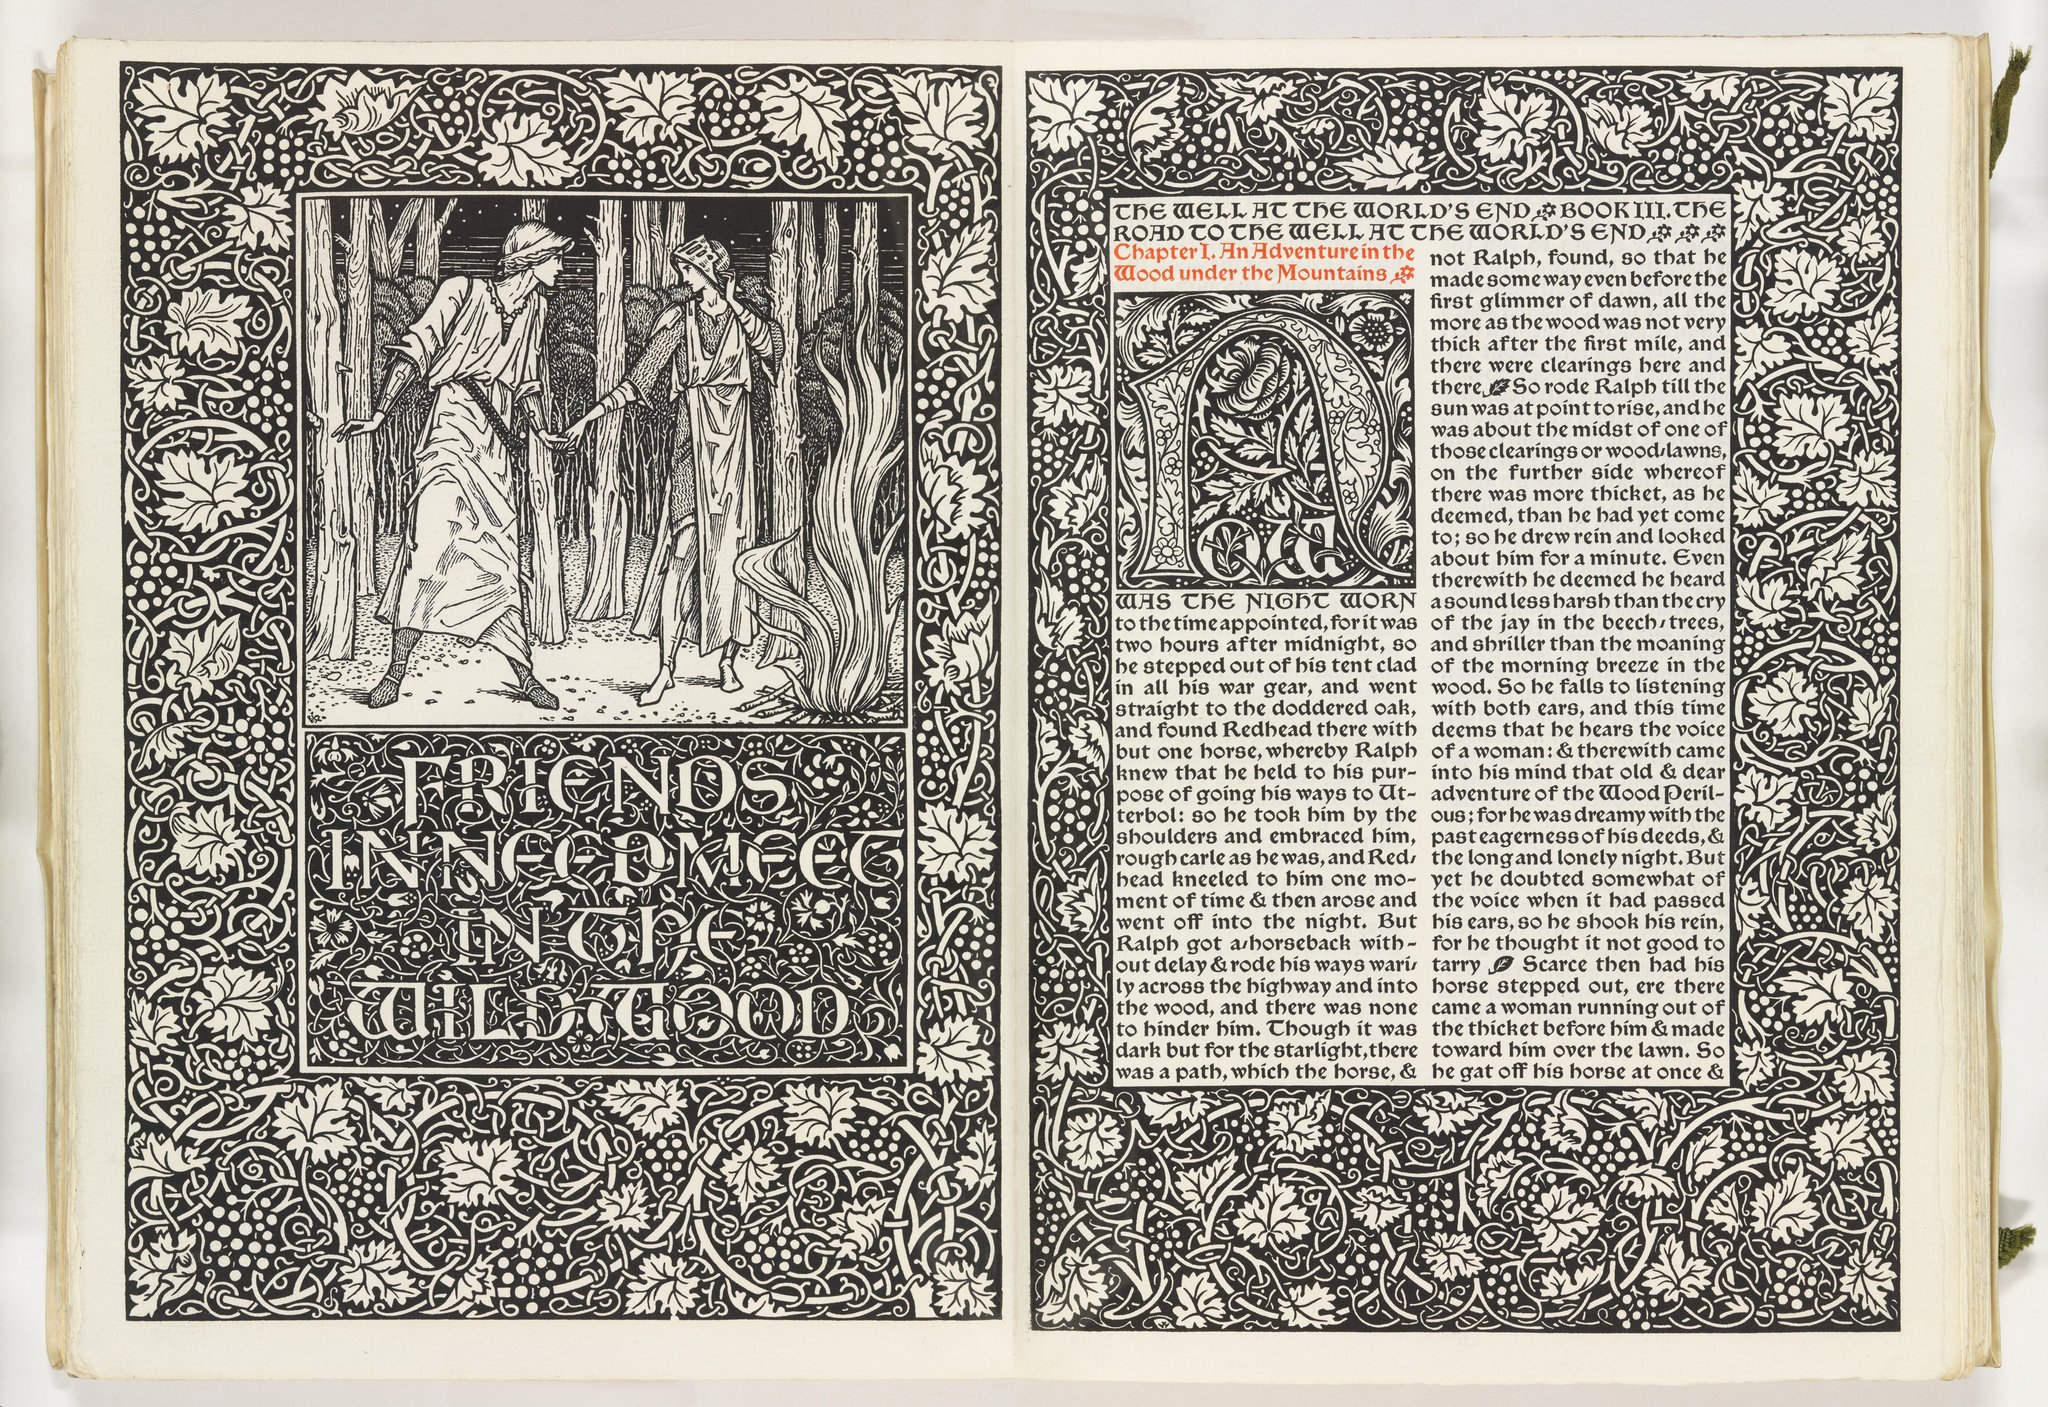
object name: book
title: The Well at the World's End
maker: william morris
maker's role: designer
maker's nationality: british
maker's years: 1834-1896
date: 1896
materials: parchment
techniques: bookbinding, woodcut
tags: men,women